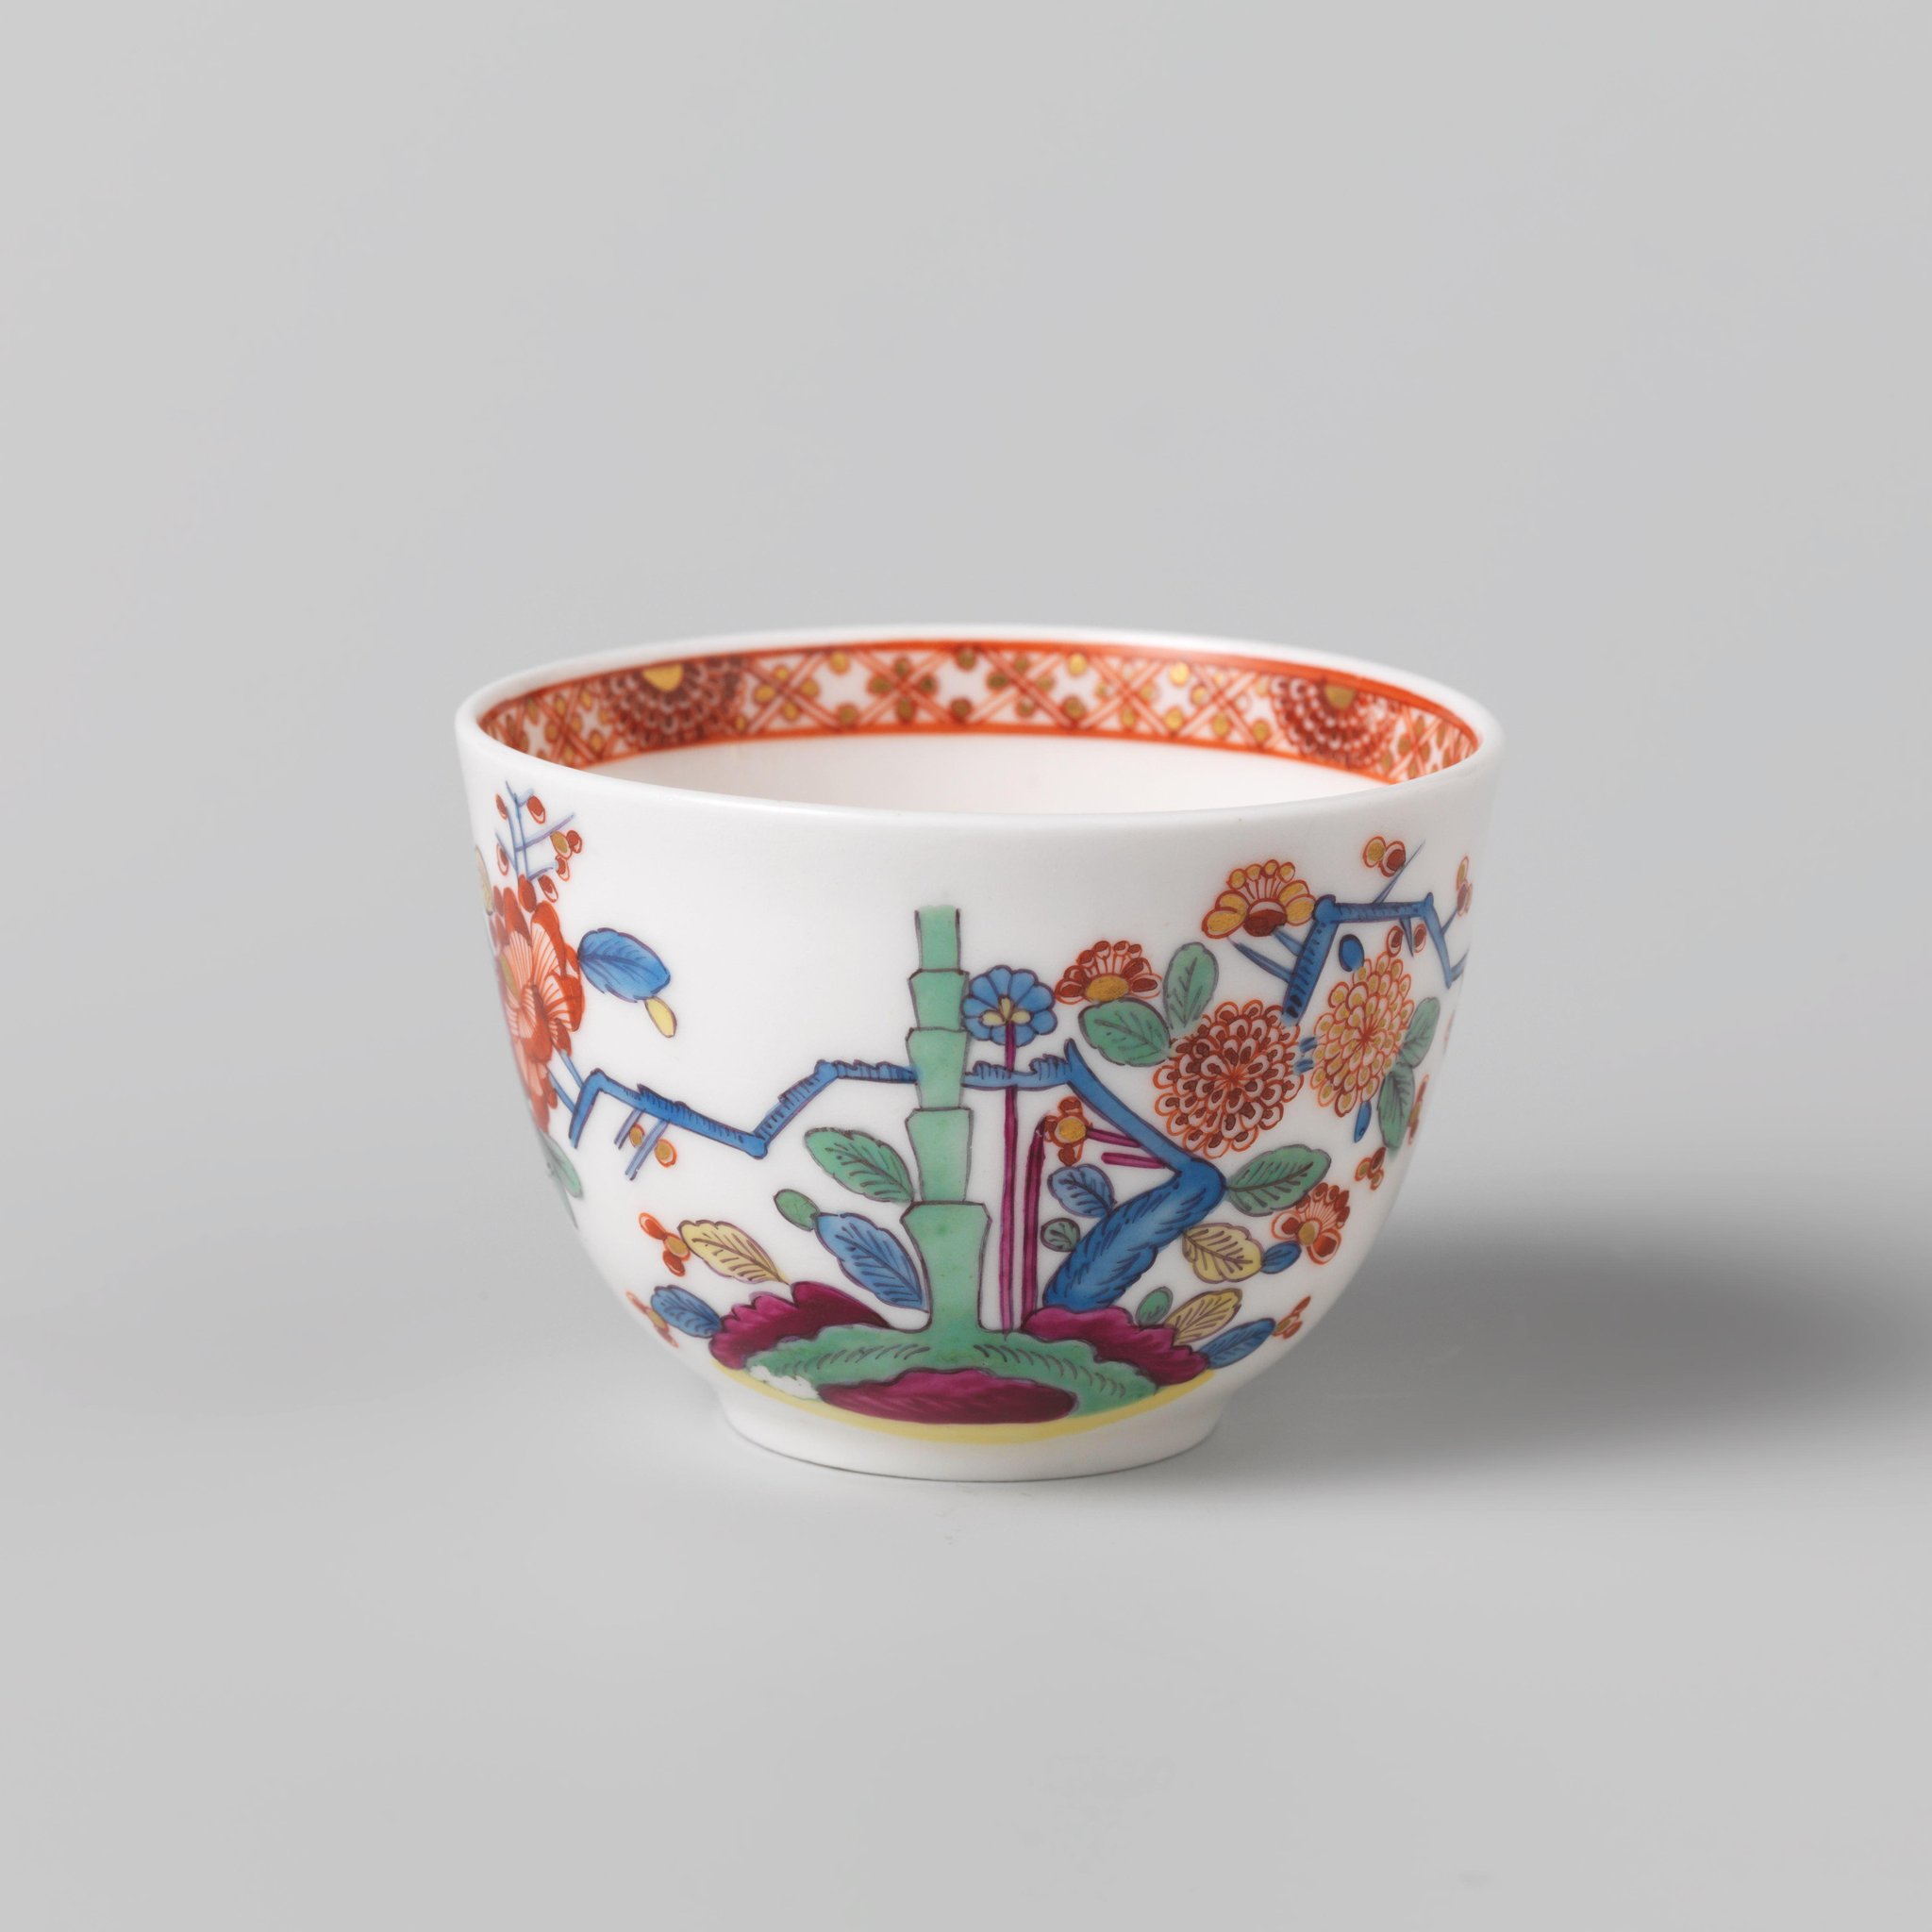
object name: cup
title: Kop van porselein (Loosdrecht) met decor van bloesemtakken in Kakiemon-stijl.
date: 1775-1785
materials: porcelain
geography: loosdrecht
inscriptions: signature and date: ‘in blauw onderglazuur: M.O.L. en ingekrast: L 48’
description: Cup and saucer. Porcelain. Loosdrecht, factory under Johannes de Mol, c. 1778 - 1780.